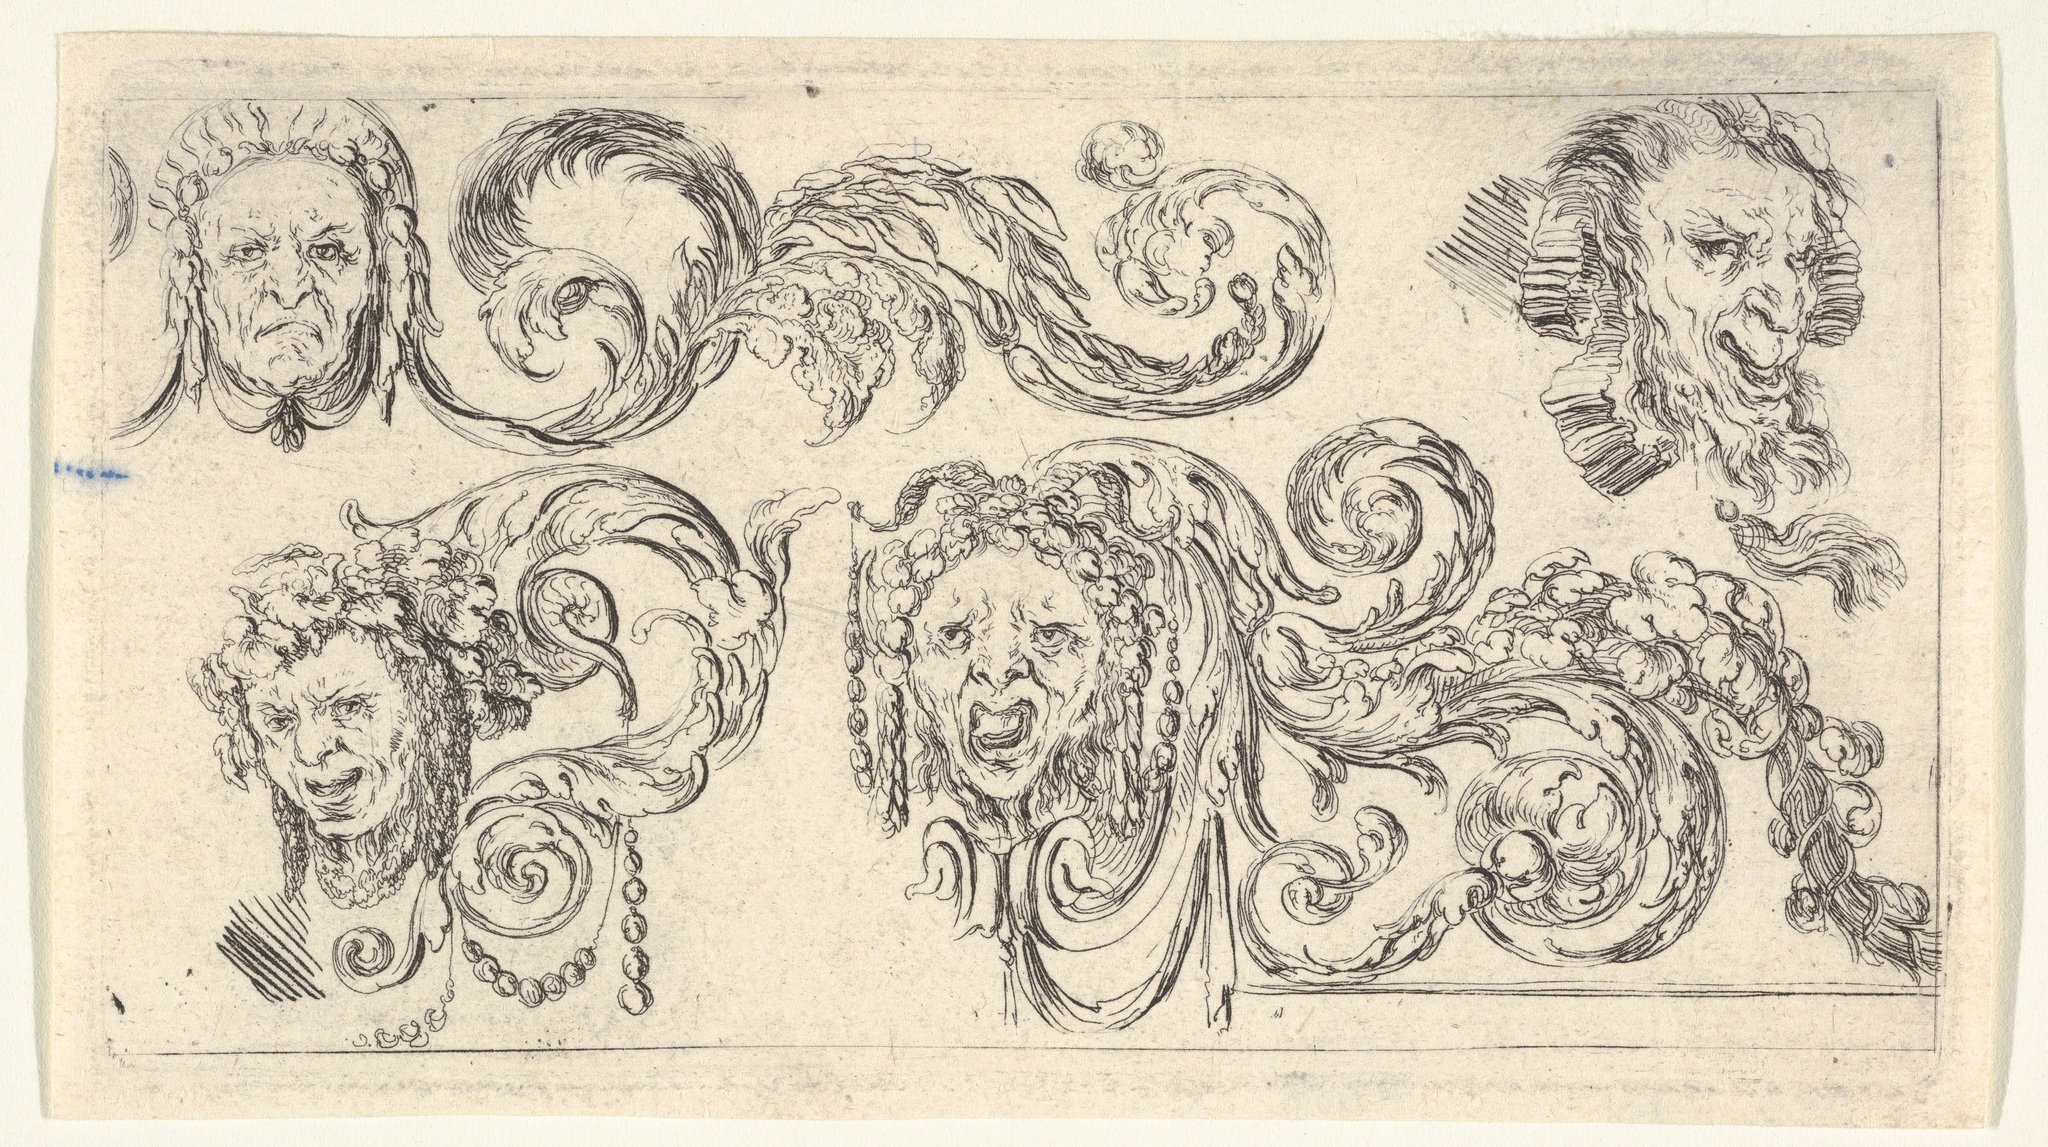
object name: print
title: Four grotesque heads with scrollwork, plate 8 from "Friezes, foliage, and grotesques" (Frises, feuillages et grotesques)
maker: stefano della bella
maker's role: artist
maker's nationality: italian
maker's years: 1610-1664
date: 1638-1643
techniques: etching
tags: ornament,heads,men